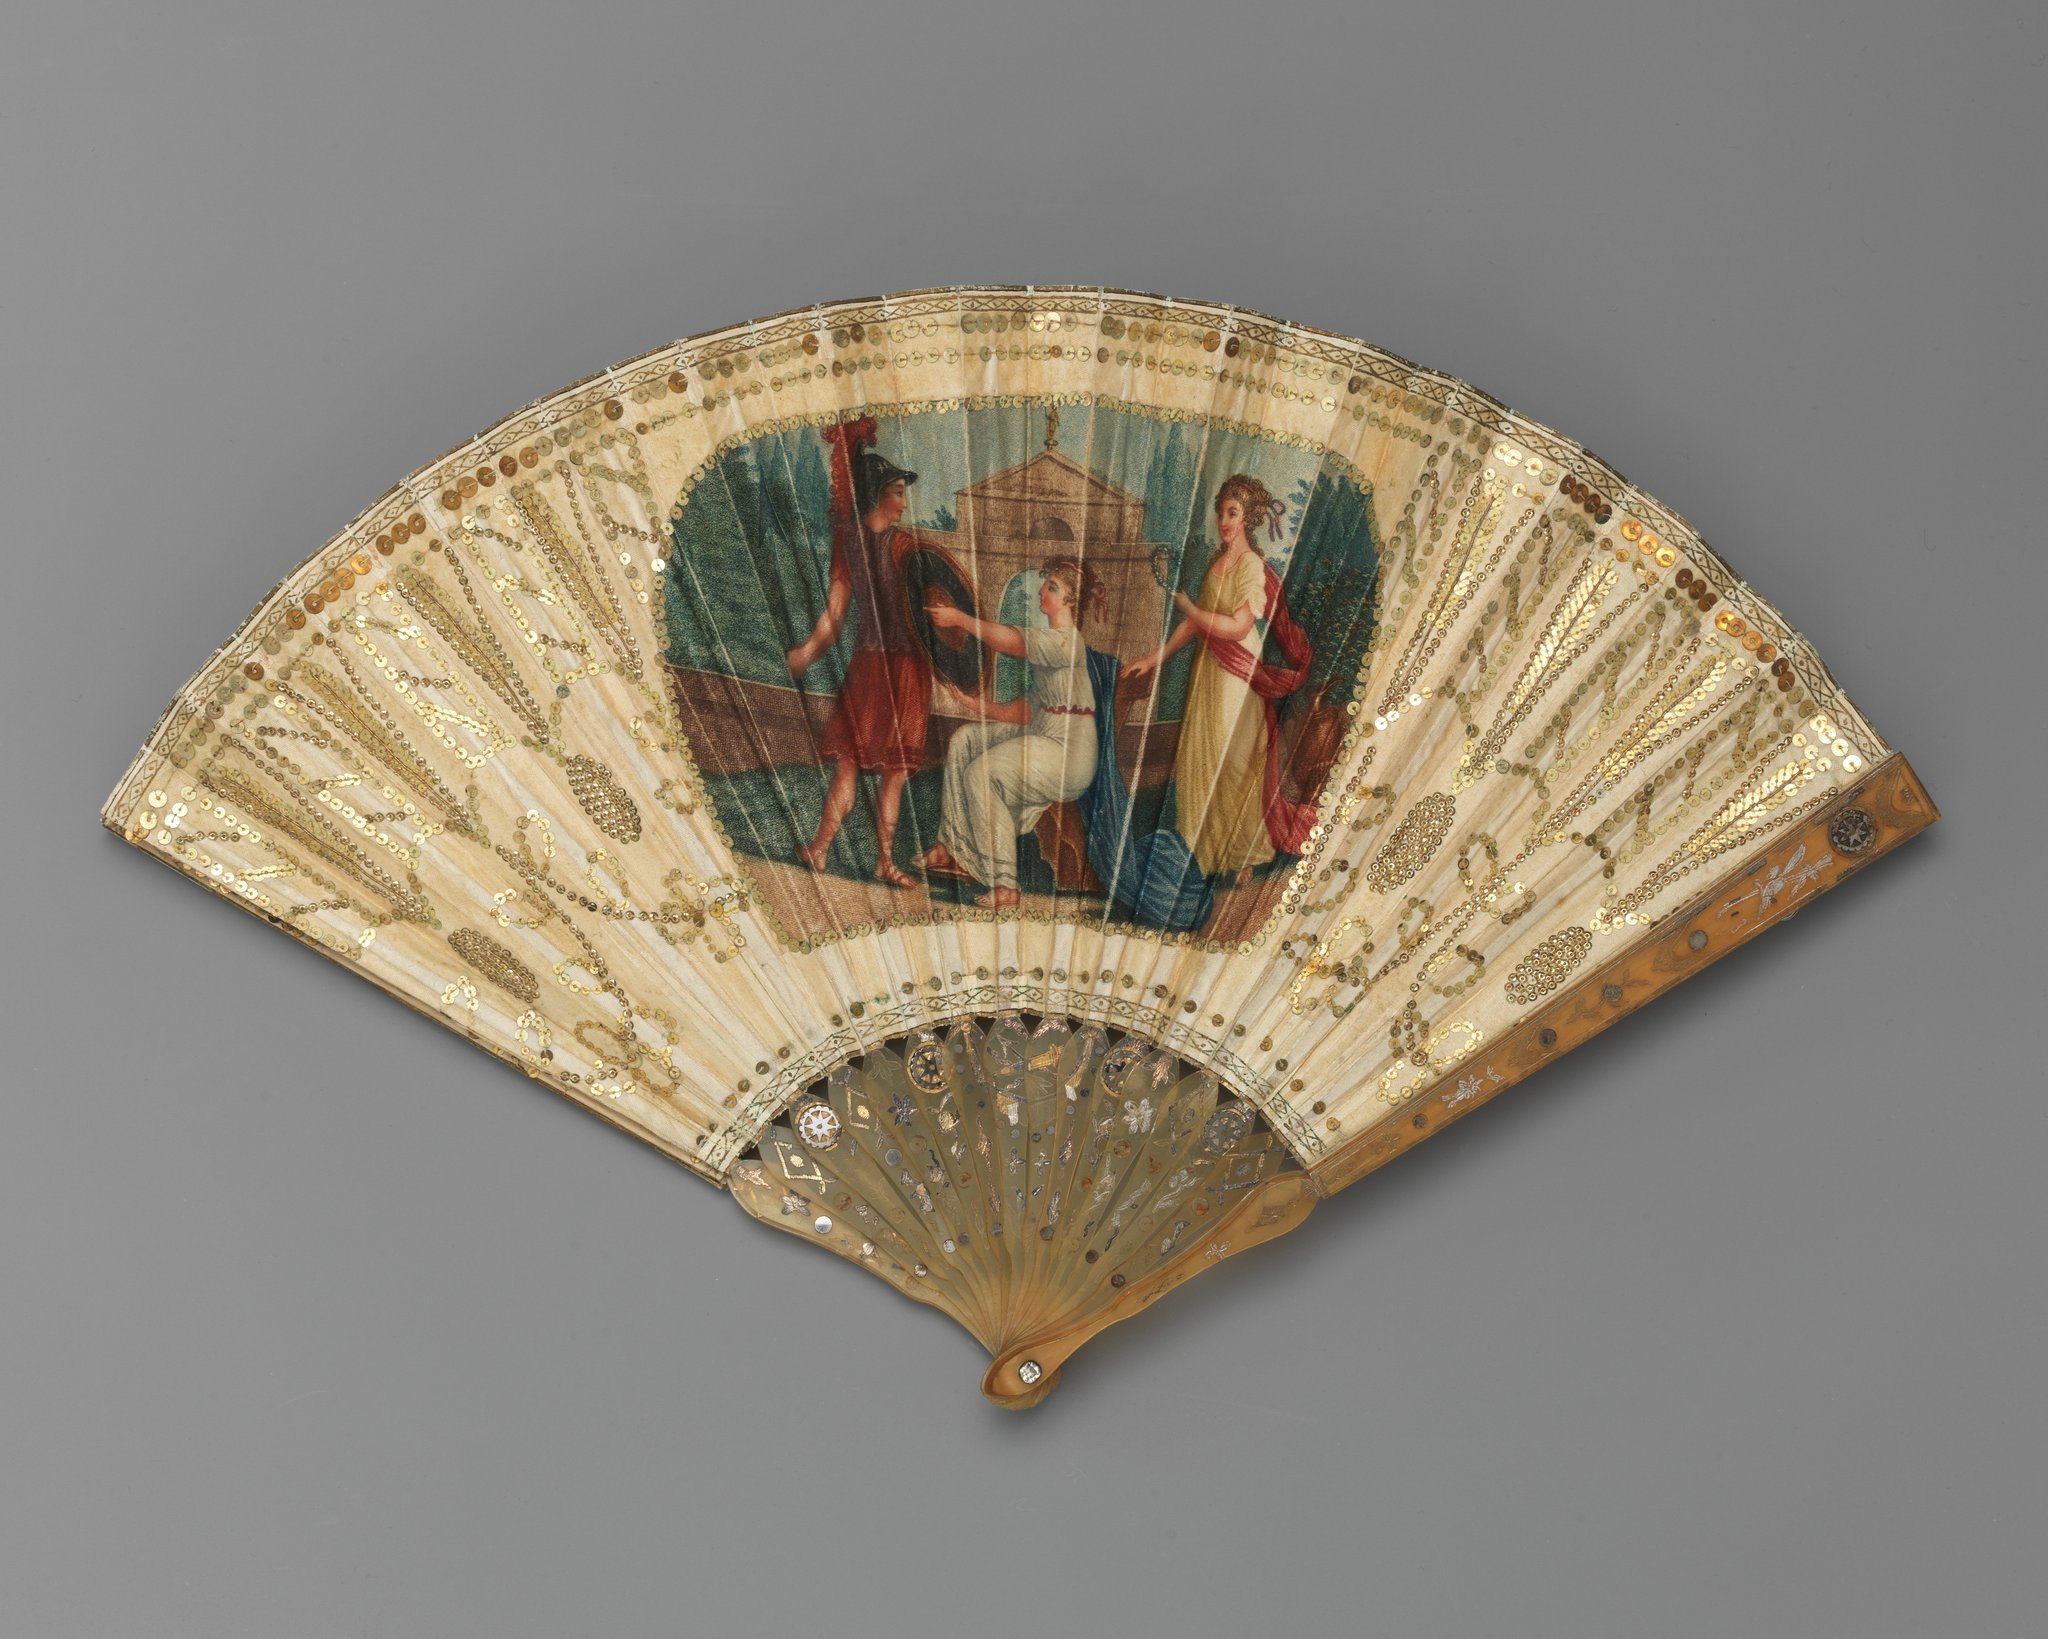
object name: fan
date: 1767-1800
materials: glass, horn, metal, parchment, silk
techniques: embroidery, gilding, painting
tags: men,women